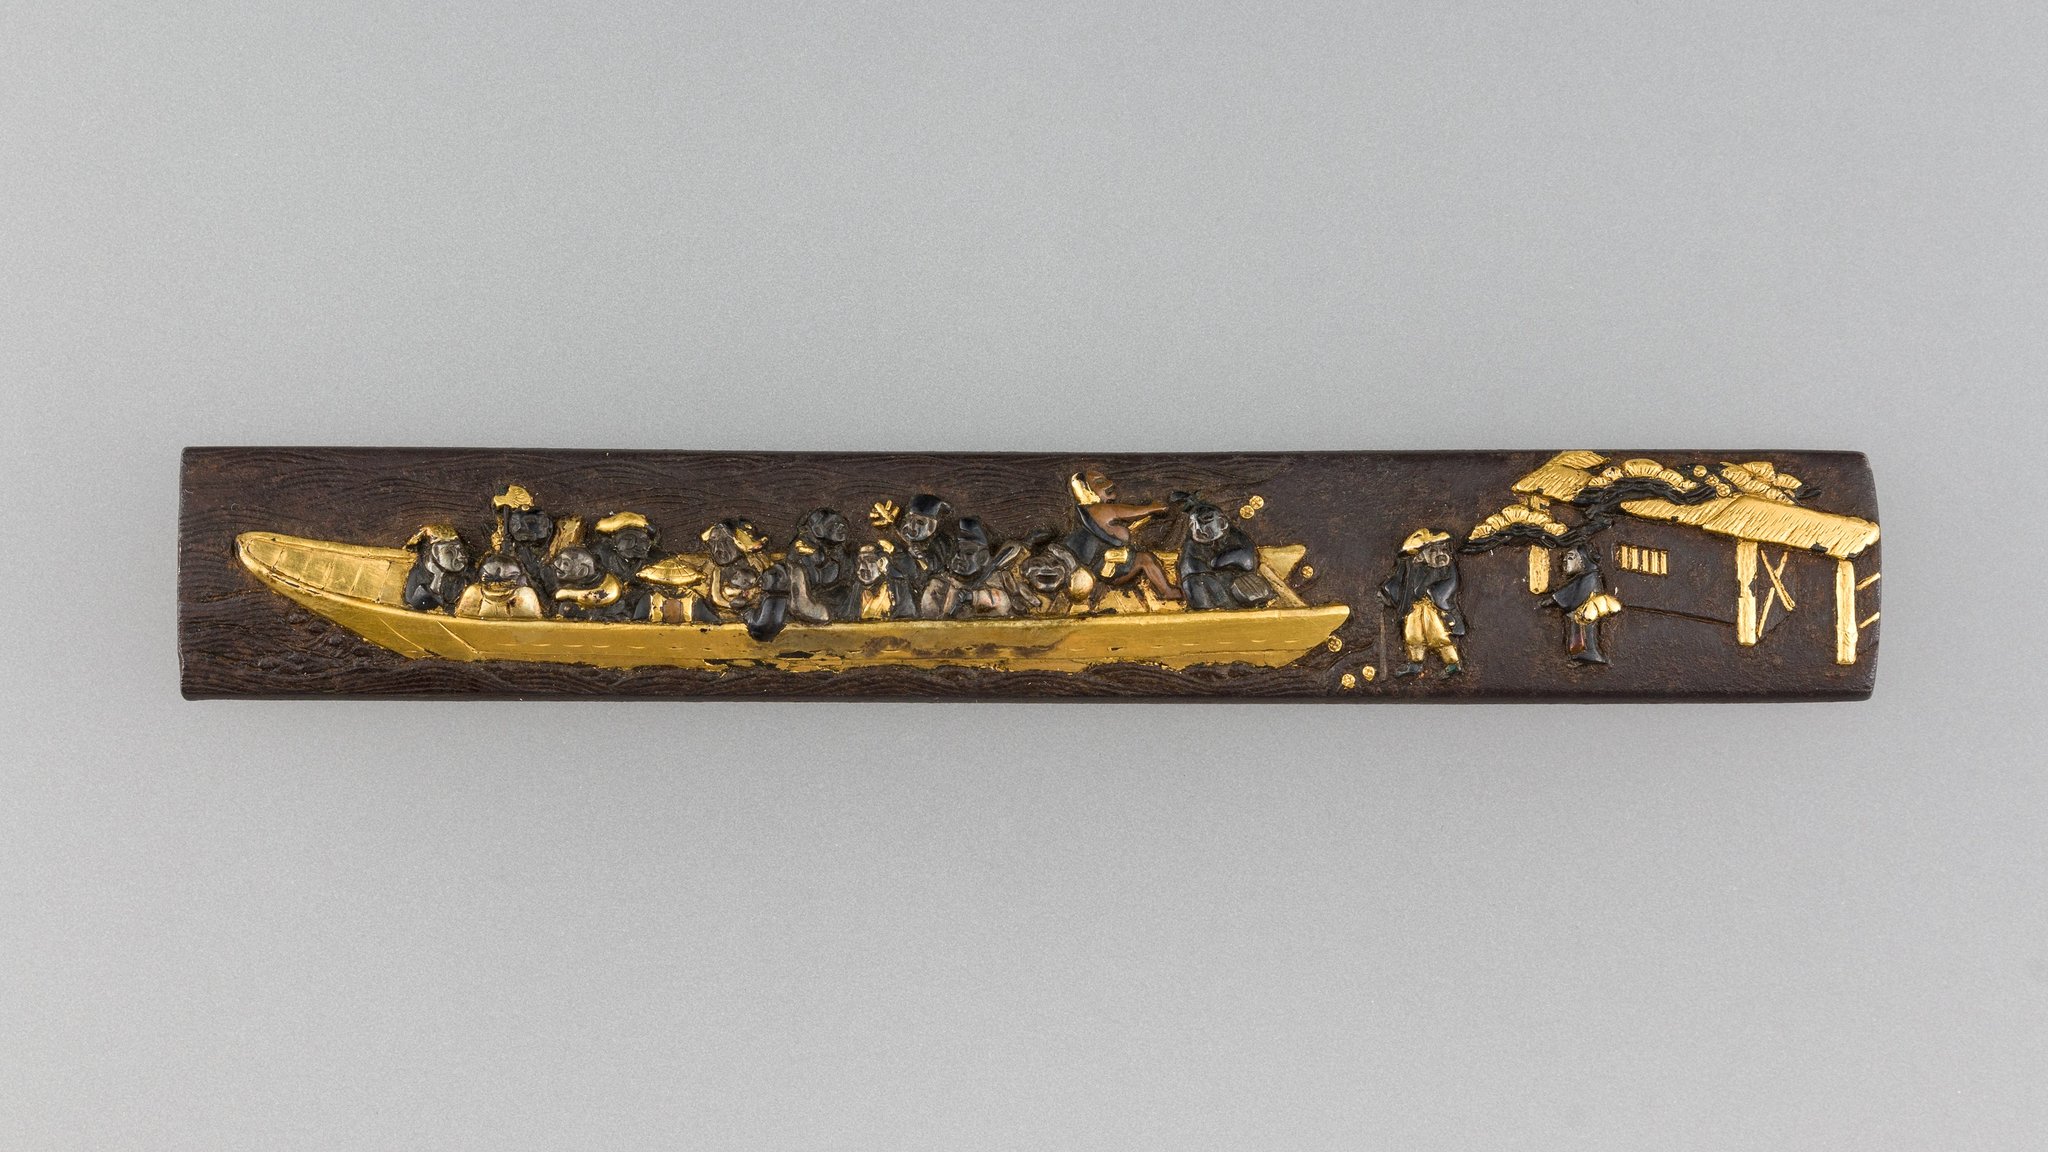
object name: knife handle kozuka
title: Knife Handle (Kozuka)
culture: japanese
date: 1701-1800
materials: copper, gold alloy, gold, iron, silver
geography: japan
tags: human figures,boats